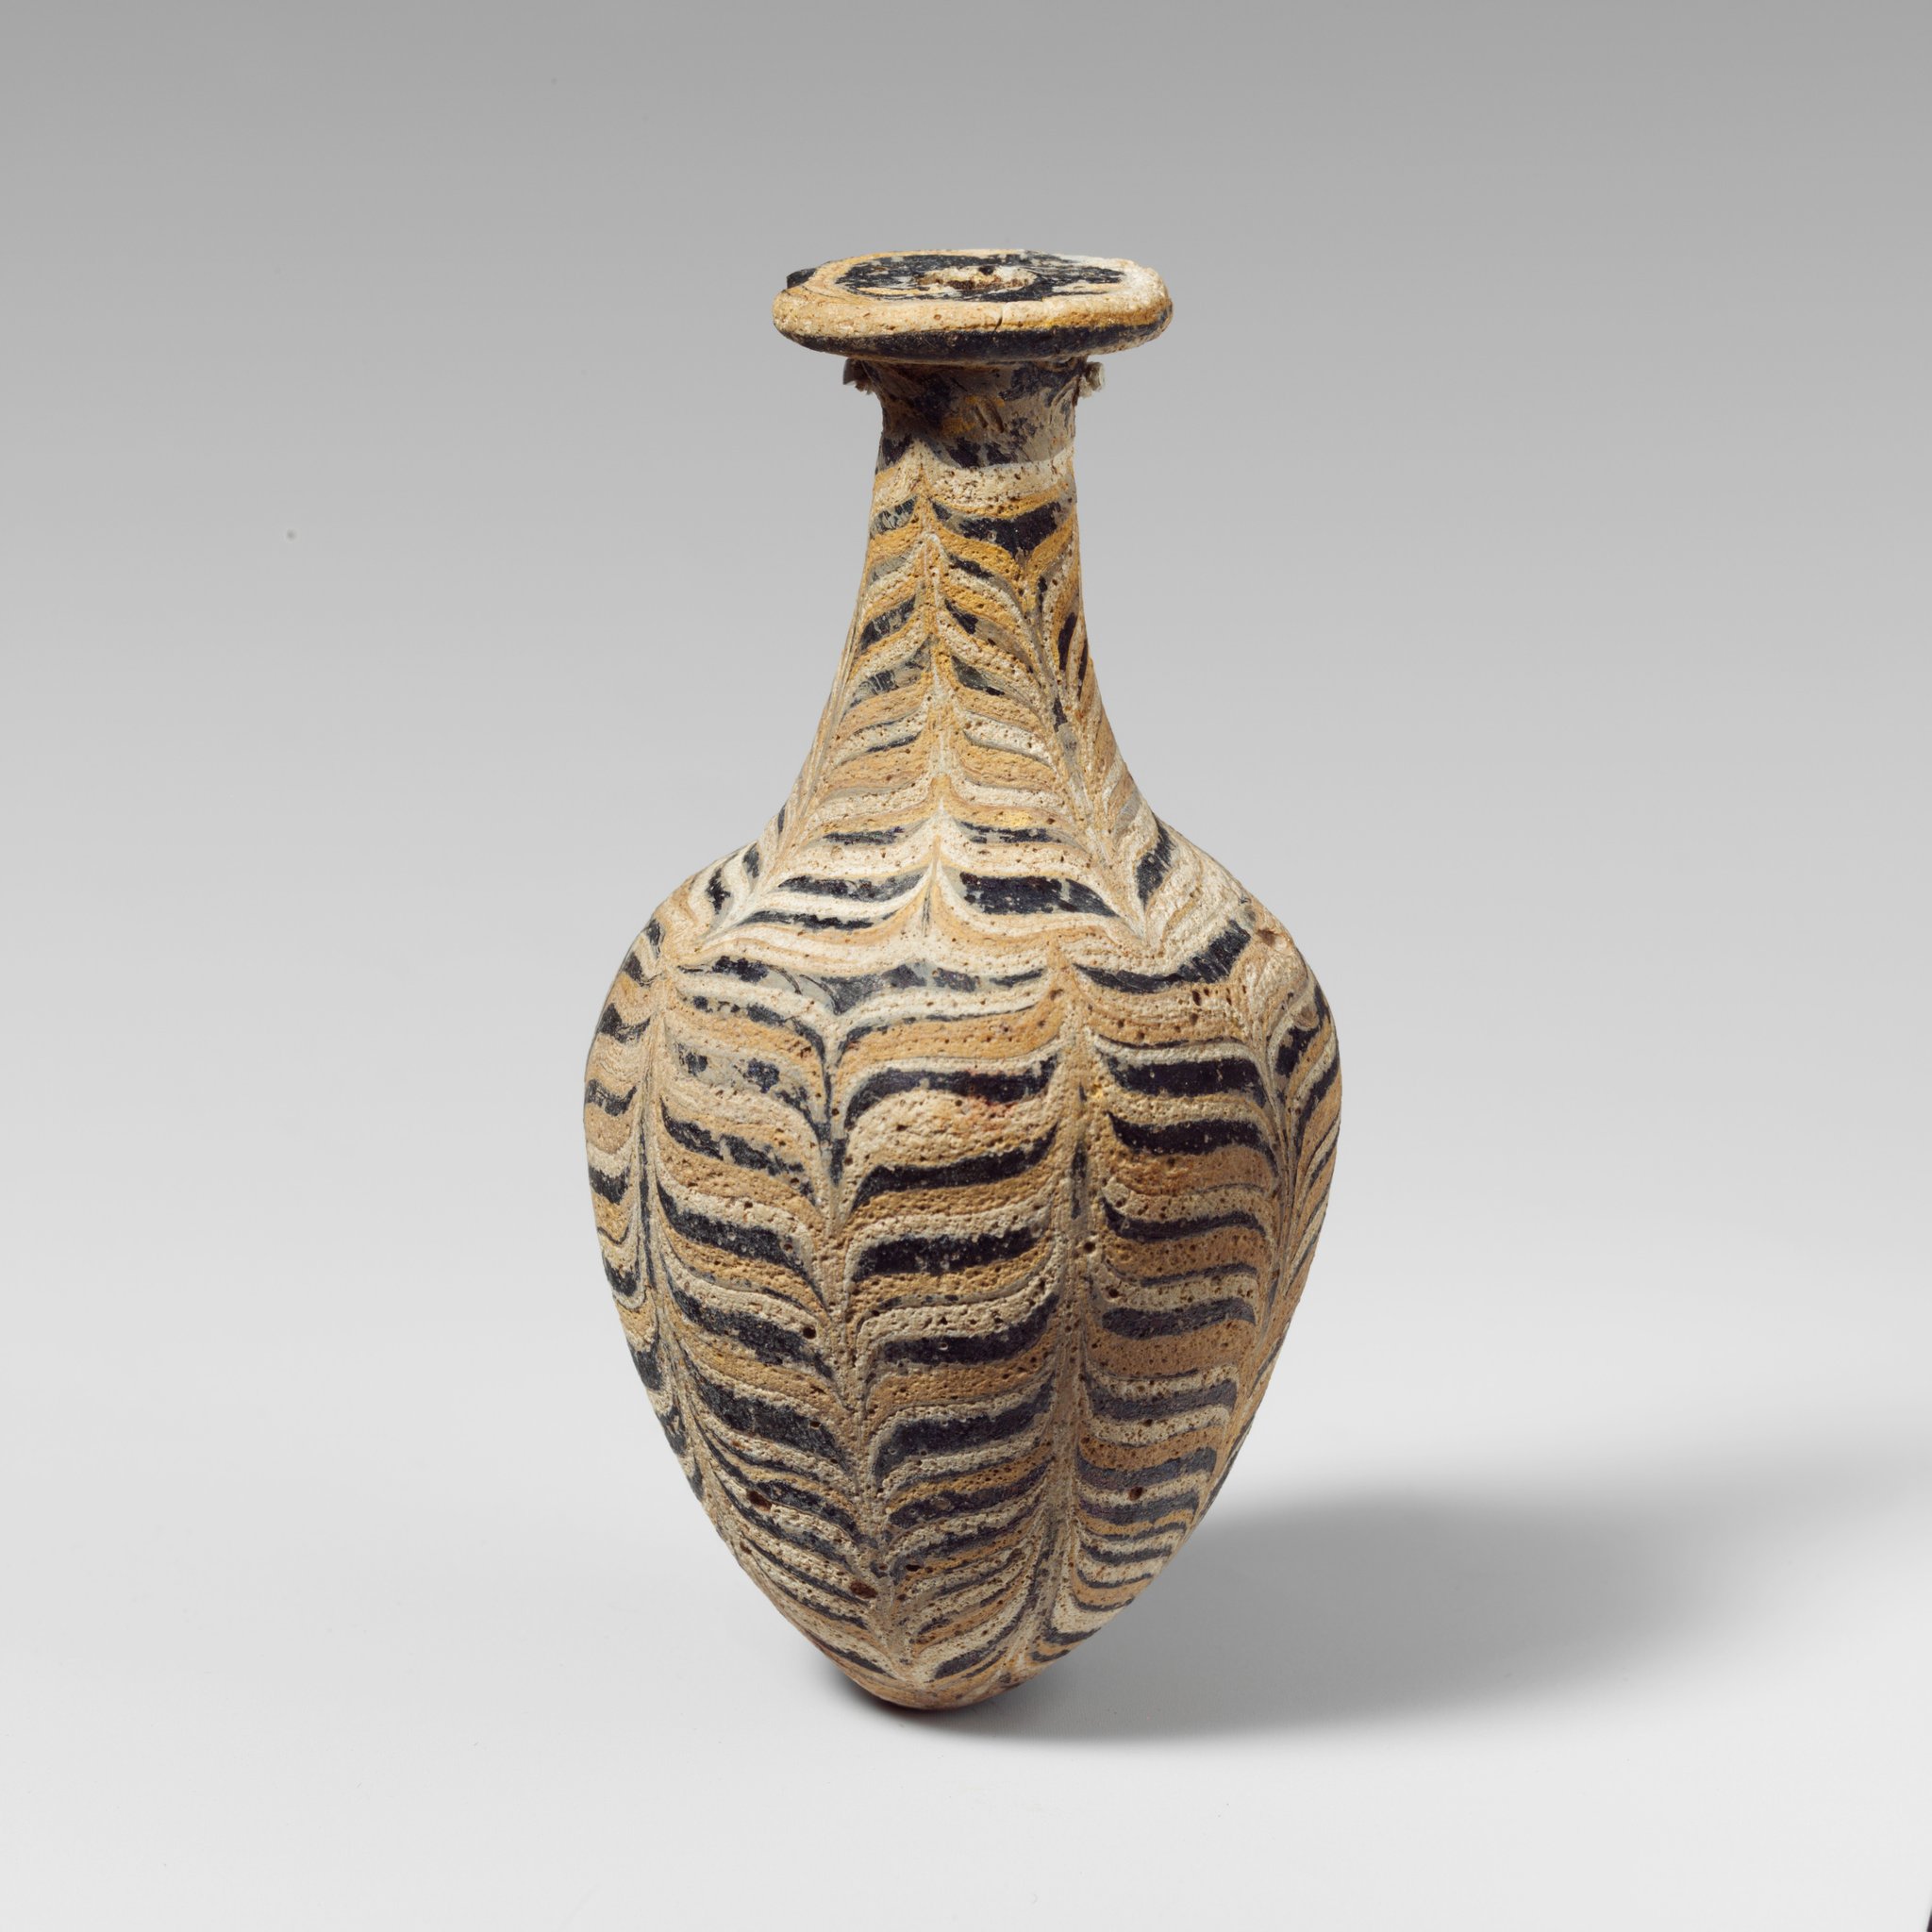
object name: amphoriskos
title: Glass amphoriskos (perfume bottle)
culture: greek, eastern mediterranean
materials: glass